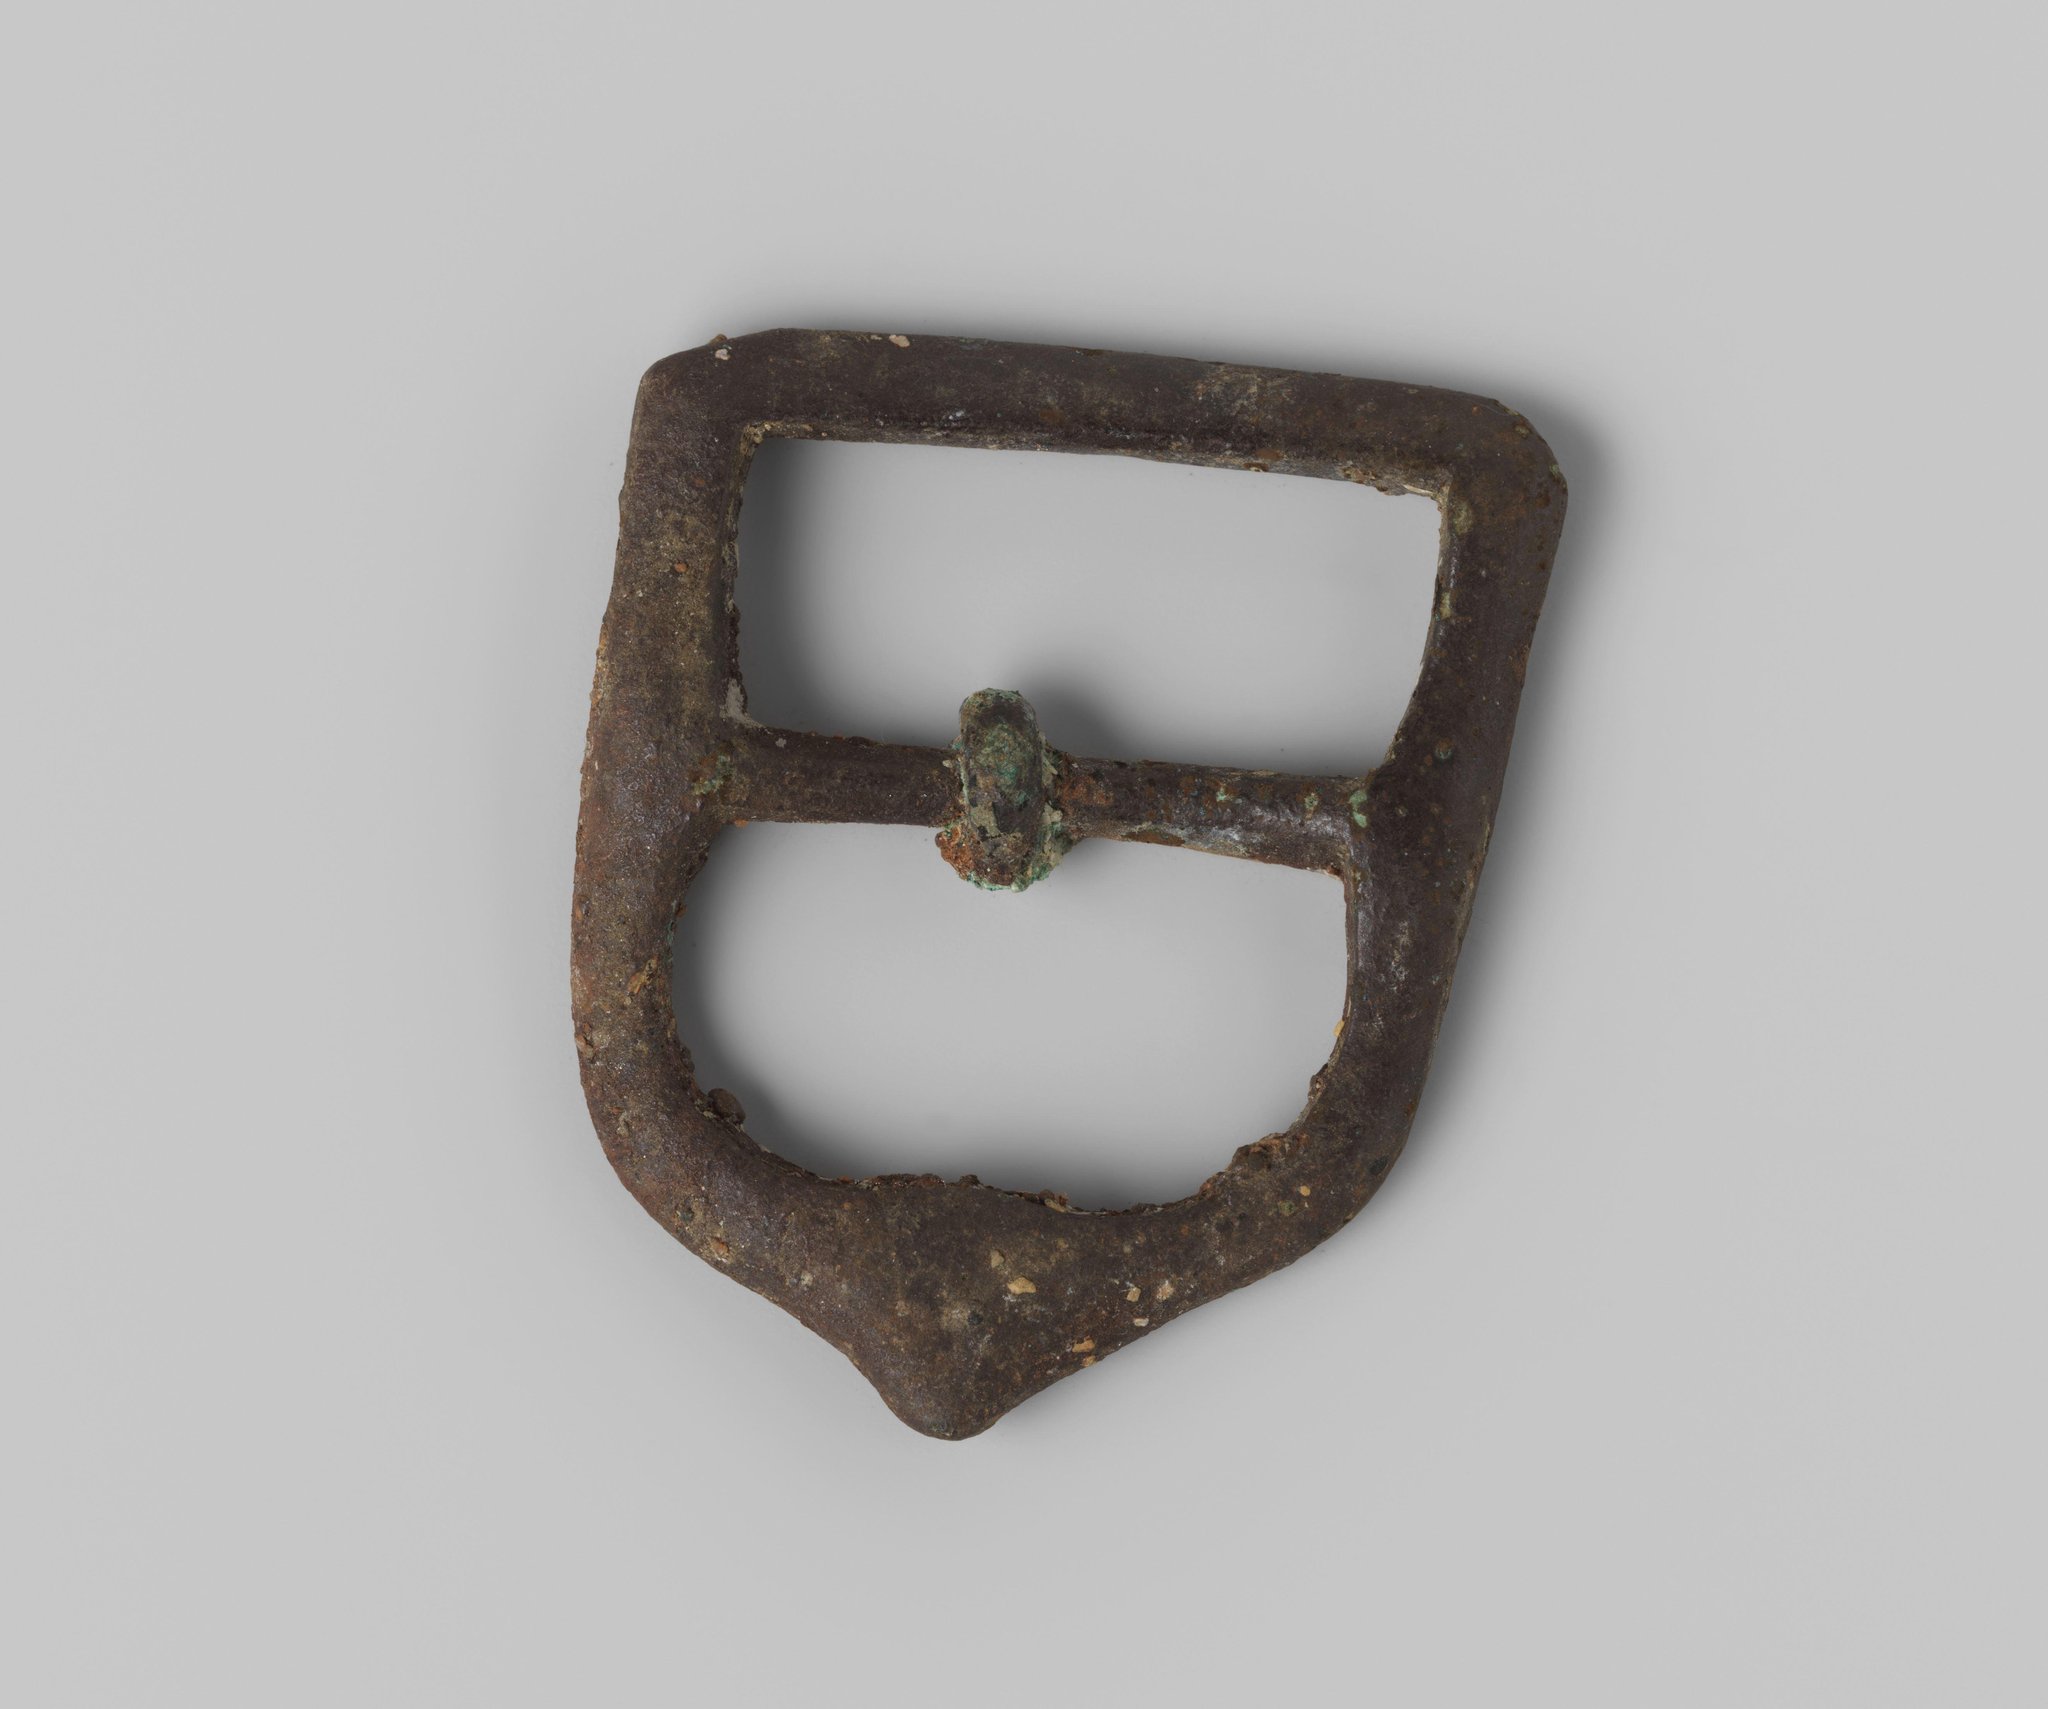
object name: belt buckle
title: Riemgesp uit het wrak van de Oost-Indiëvaarder Hollandia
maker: Anonymous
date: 1700-1743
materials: copper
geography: netherlands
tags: verenigde oostindische compagnie, hollandia (schip), annet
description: D-shaped with pointed side, fragm of ring and tongue, id. NG 1980-27H384, belt buckle.